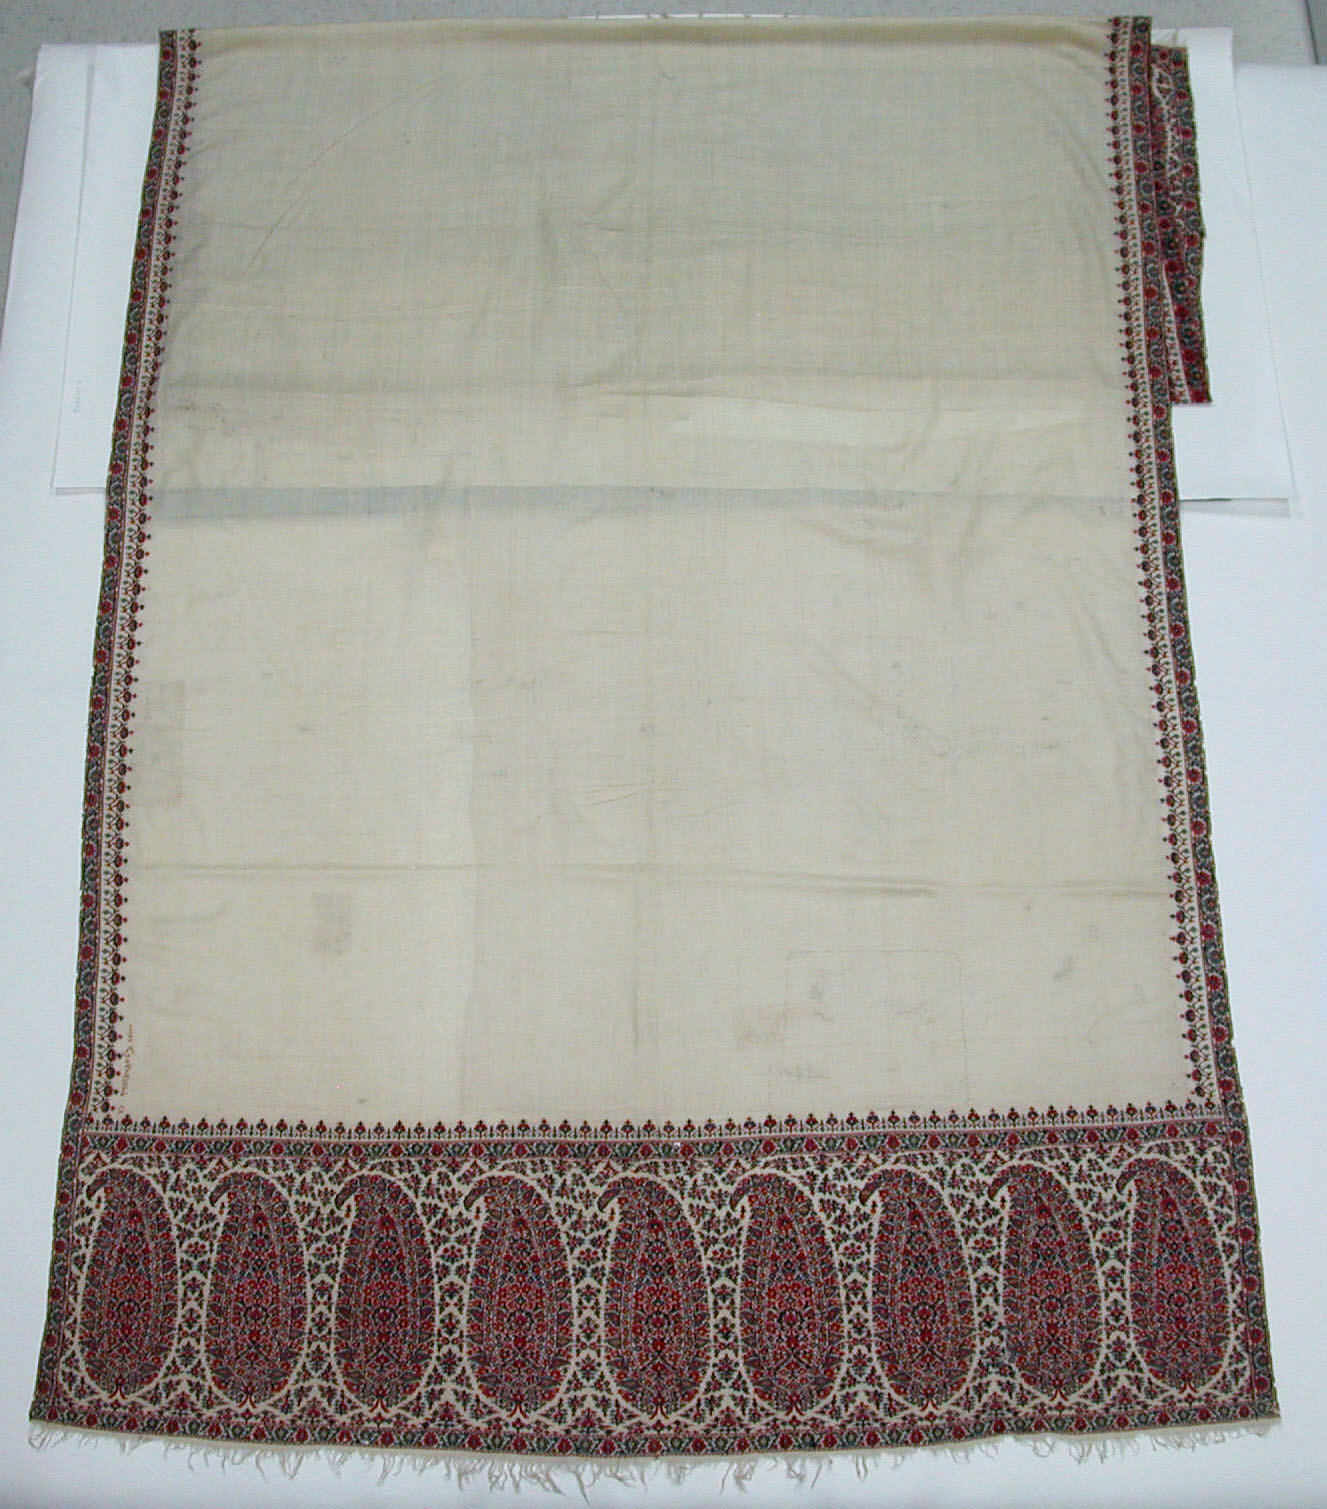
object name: shawl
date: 1826-1850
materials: silk, wool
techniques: interlocking, weave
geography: india